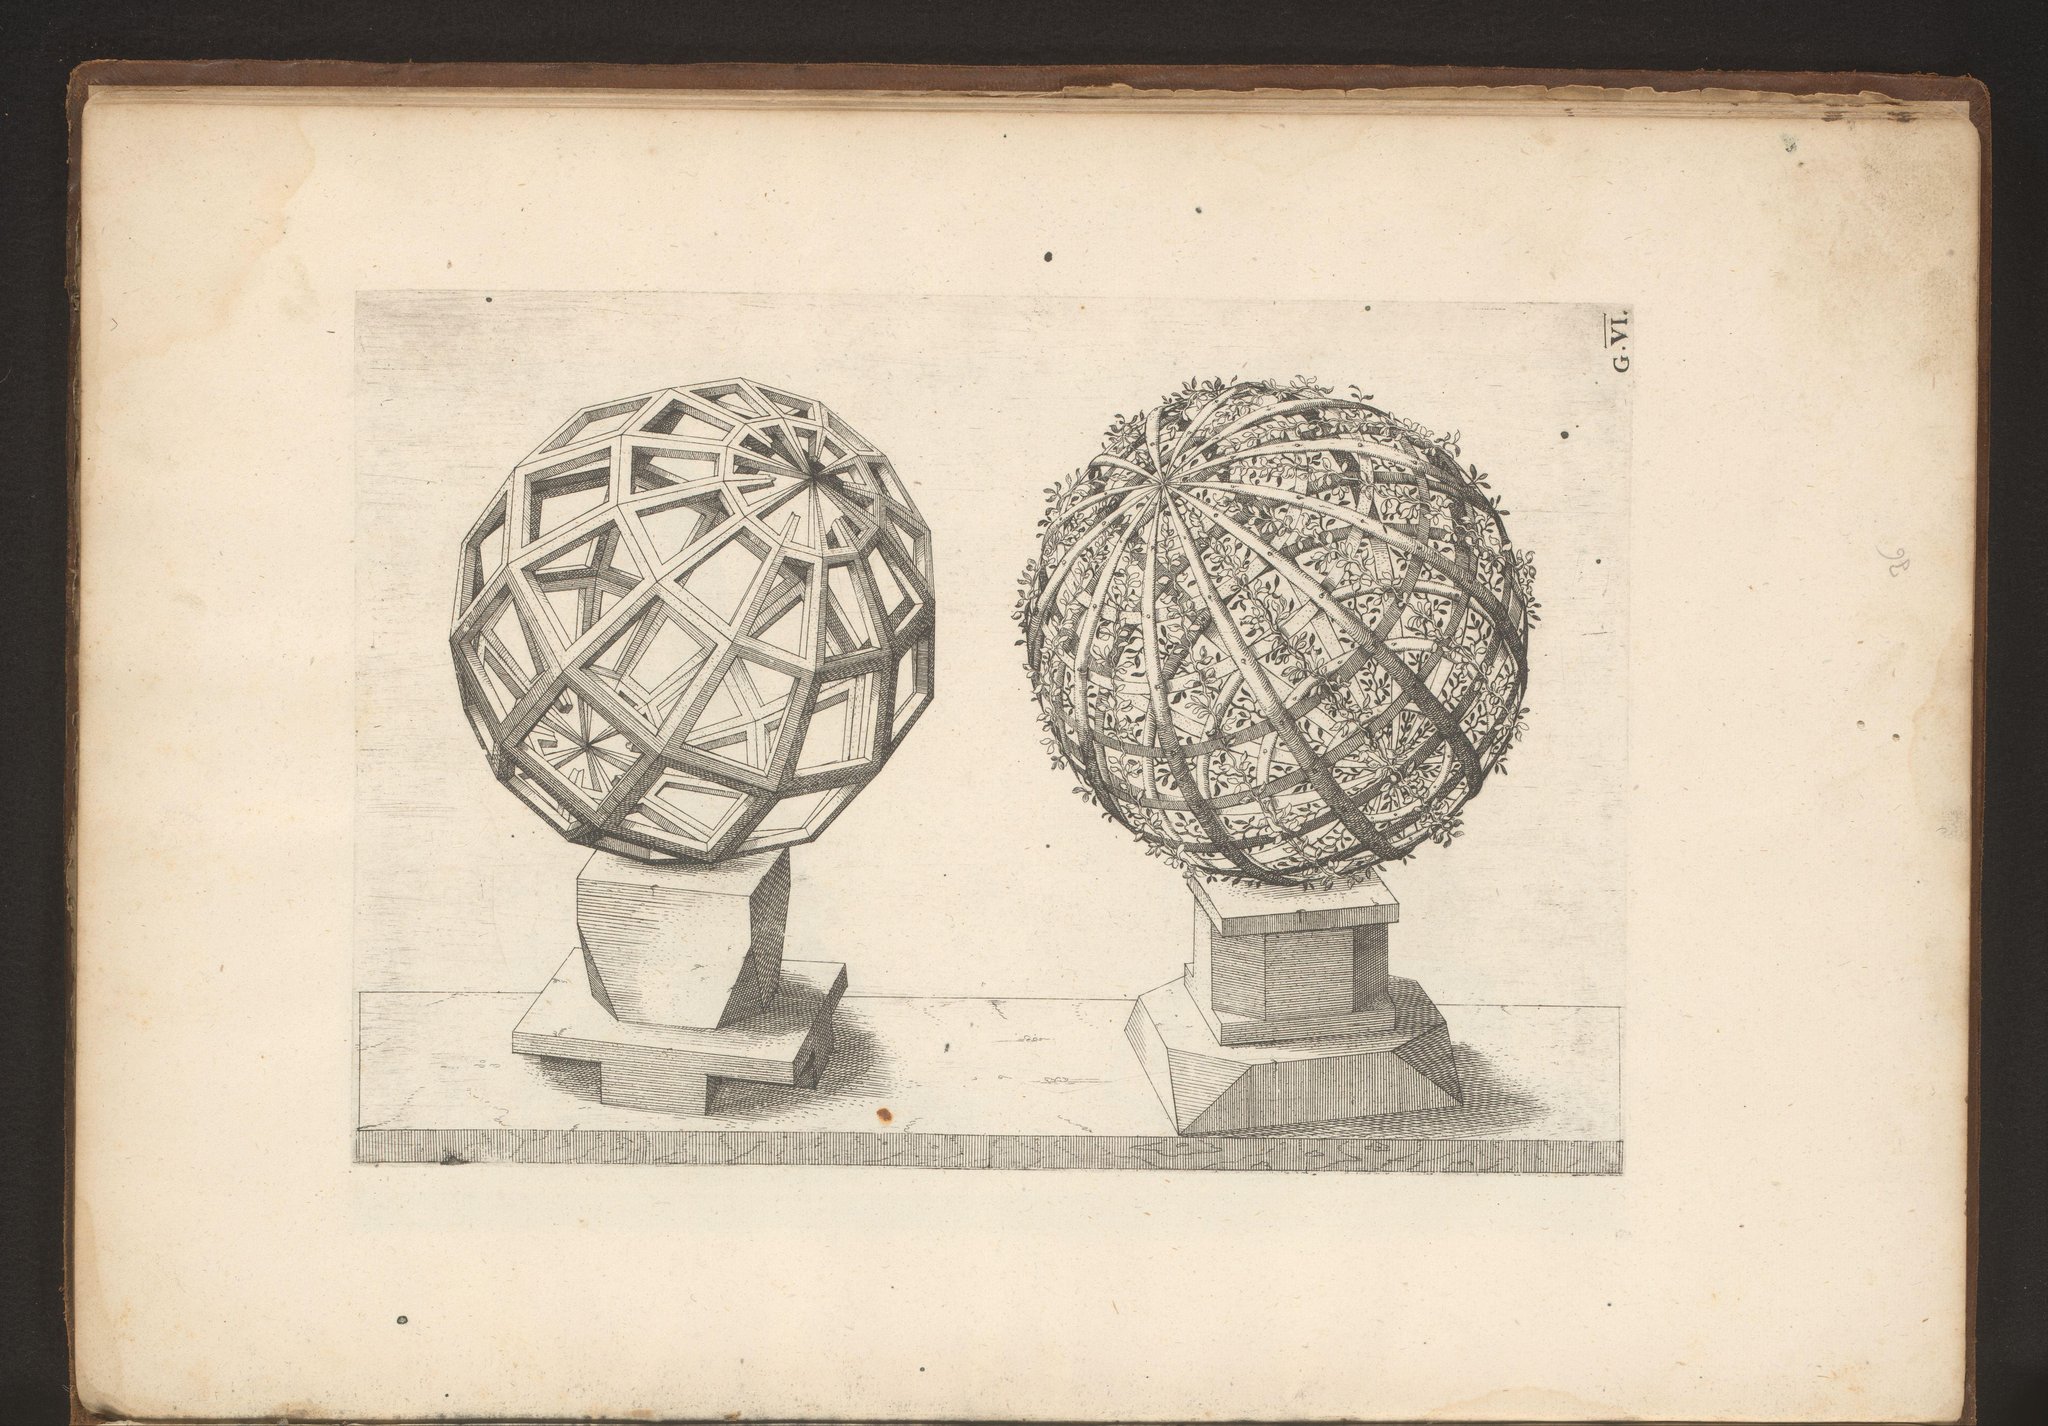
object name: print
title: Twee veelvlakken met een bol als uitgangspunt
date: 1568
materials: paper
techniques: etching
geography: nuremberg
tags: other polyhedrons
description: De geometrische figuren (polyhedra) worden van links naar rechts complexer. Rechter bol gedecoreerd met ranken. Genummerd: G.VI. Deze prent maakt deel uit van een boek.